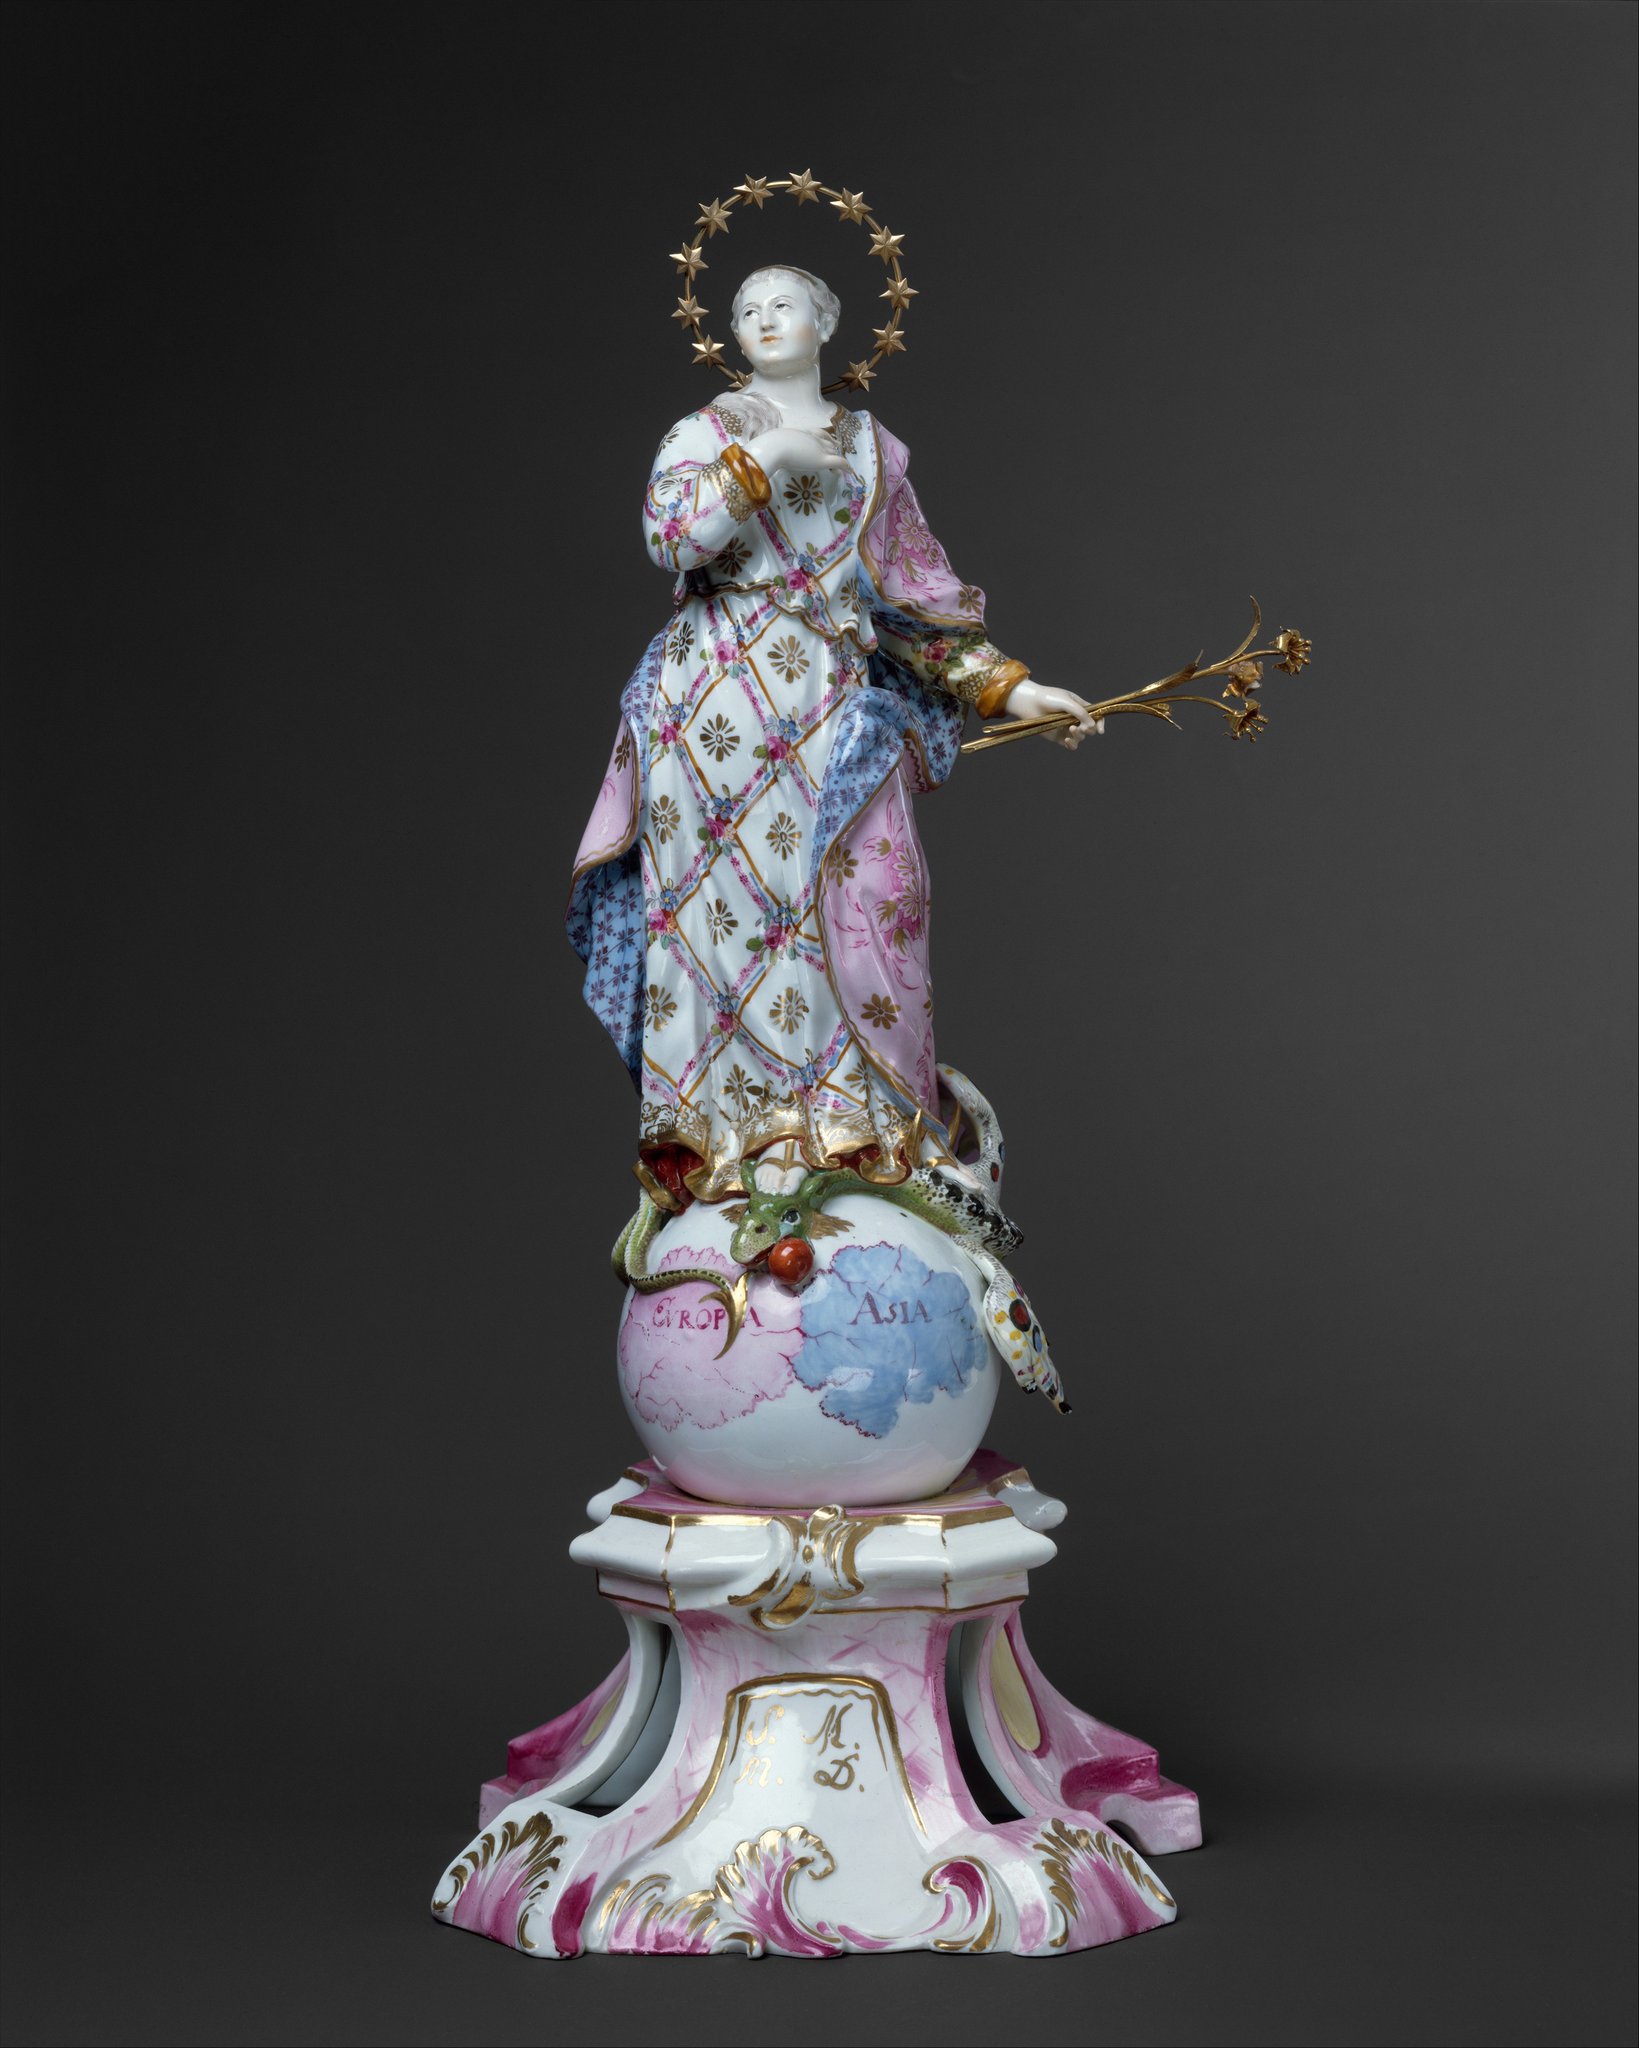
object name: figure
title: Virgin of the Immaculate Conception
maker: fulda pottery and porcelain manufactory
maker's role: manufactory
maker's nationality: german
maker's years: 1764-1789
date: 1781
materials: hard paste porcelain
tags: dragons,virgin mary,globes